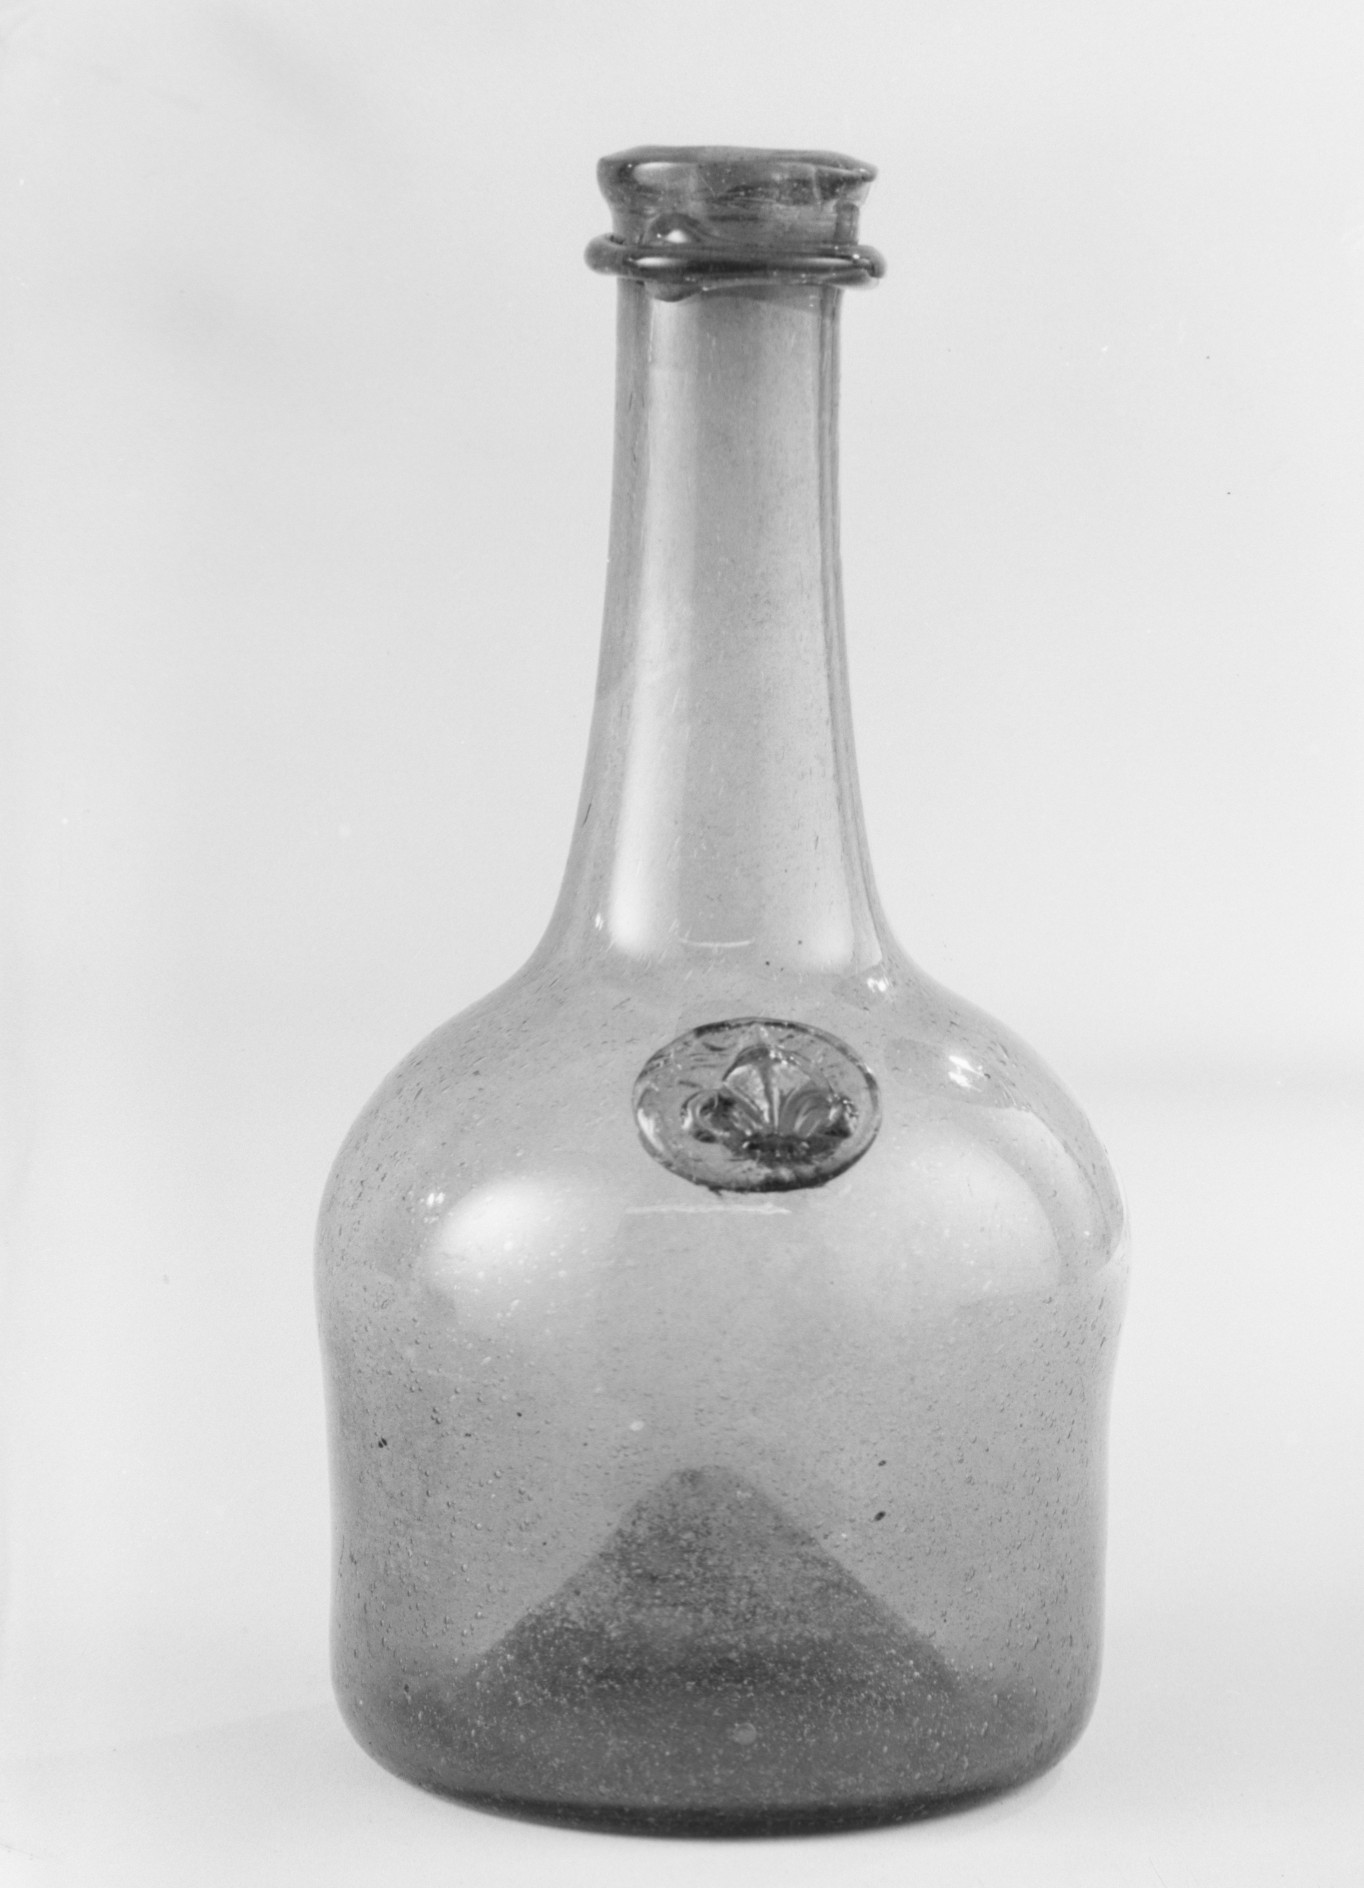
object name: bottle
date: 1701-1800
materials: glass